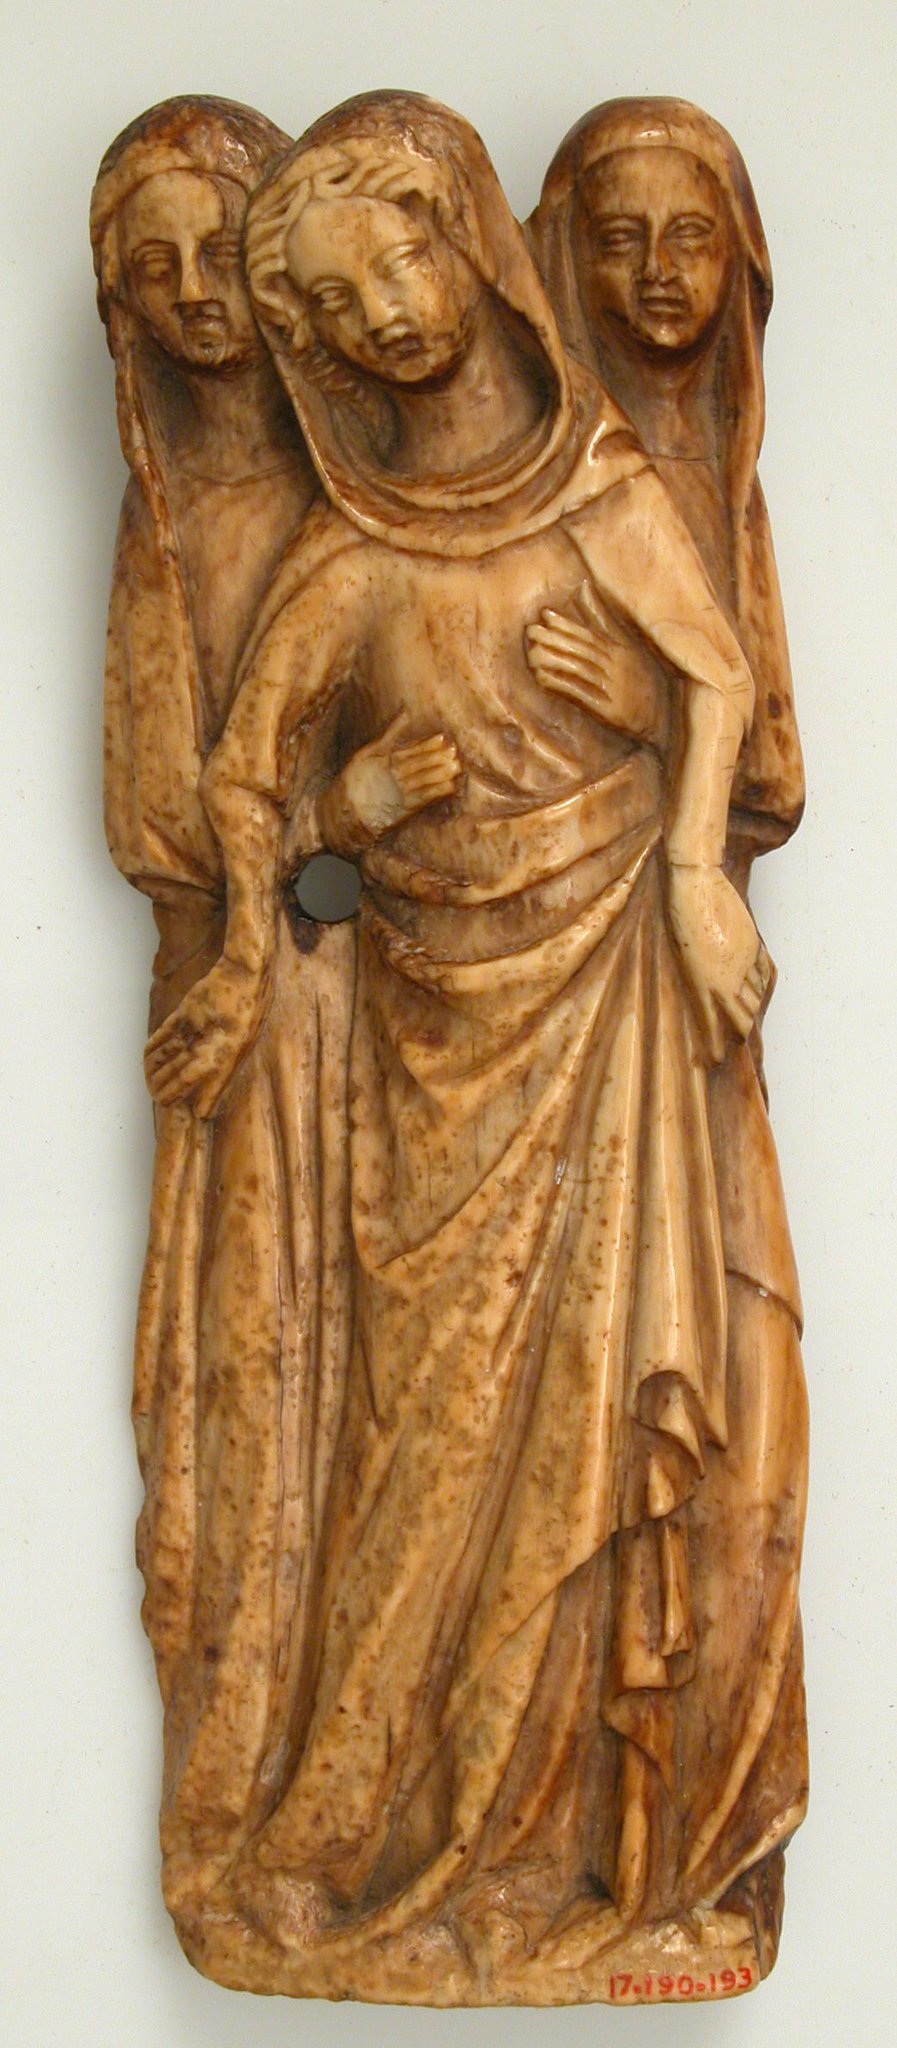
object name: relief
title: Virgin Supported by Two Holy Women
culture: french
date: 1301-1400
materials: ivory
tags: women